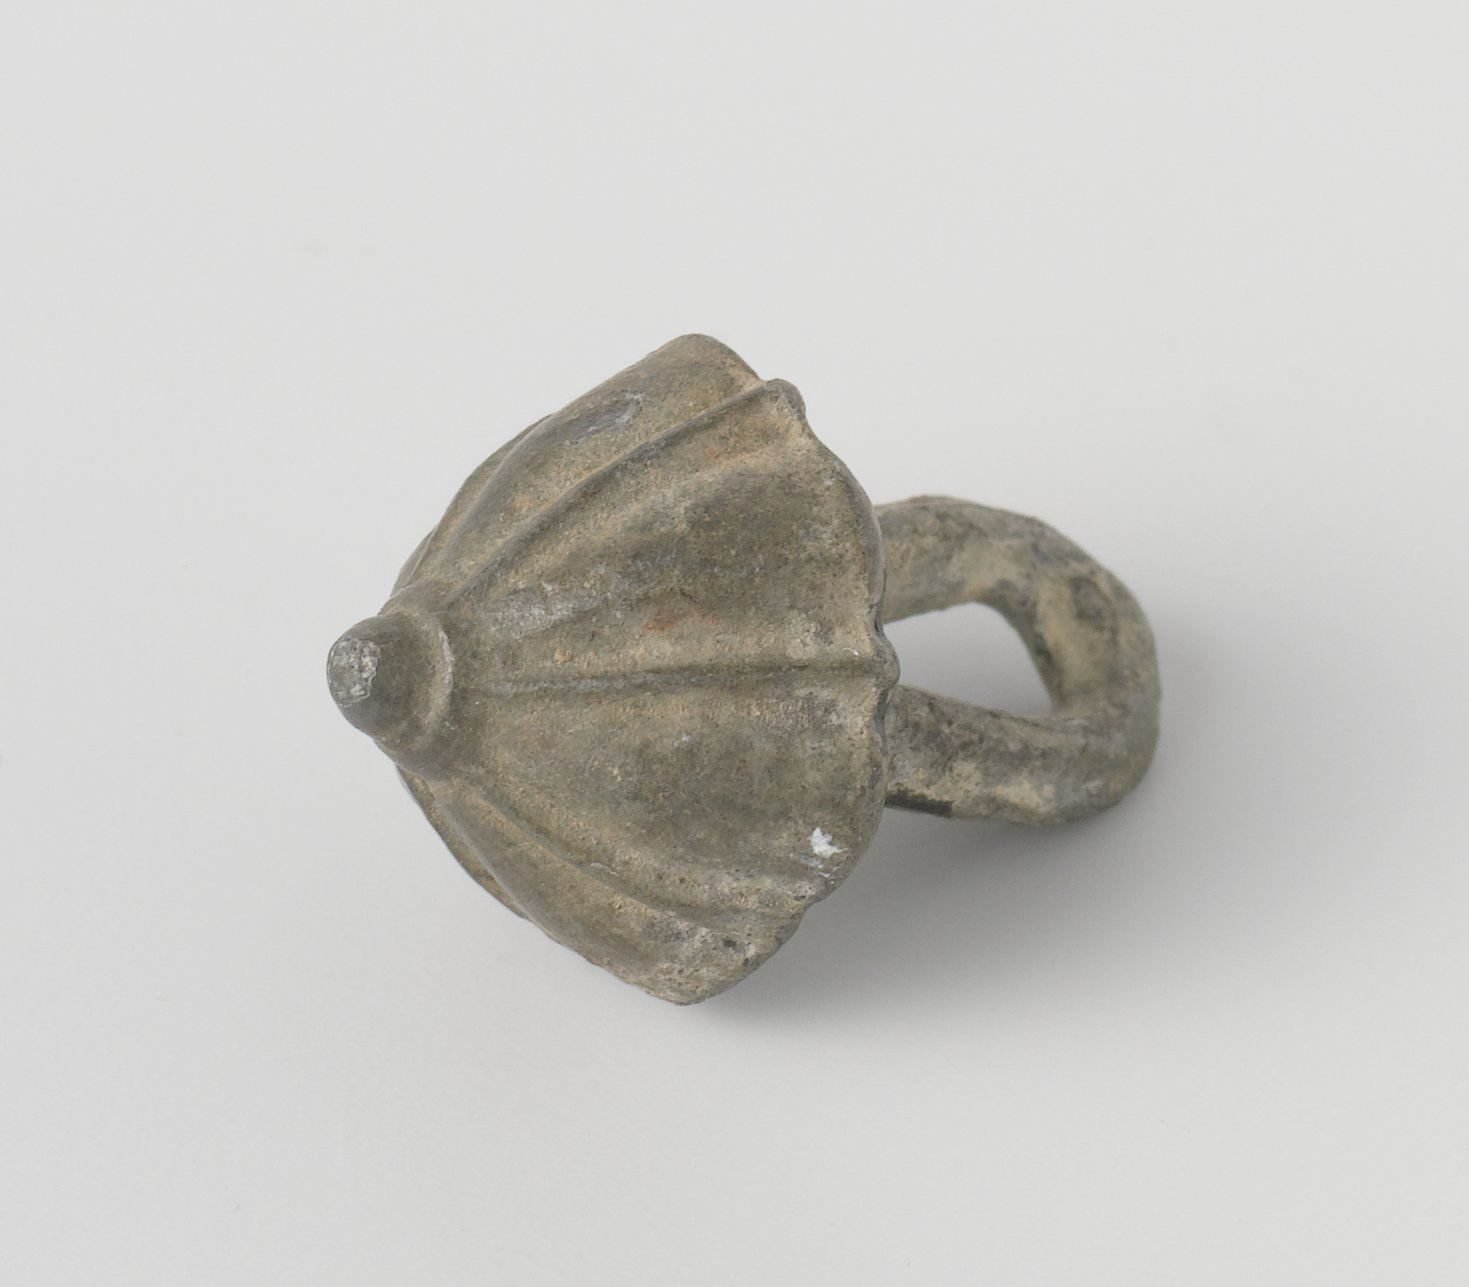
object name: button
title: Knoop, konisch met ribben en bladvormig oog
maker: Anonymous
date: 1590-1596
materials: tin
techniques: casting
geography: amsterdam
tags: willem barendsz., amsterdam, jacob van heemskerck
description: Knoop, konisch van vorm met zes ribben die in een punt samenkomen en een bladvormig oog.